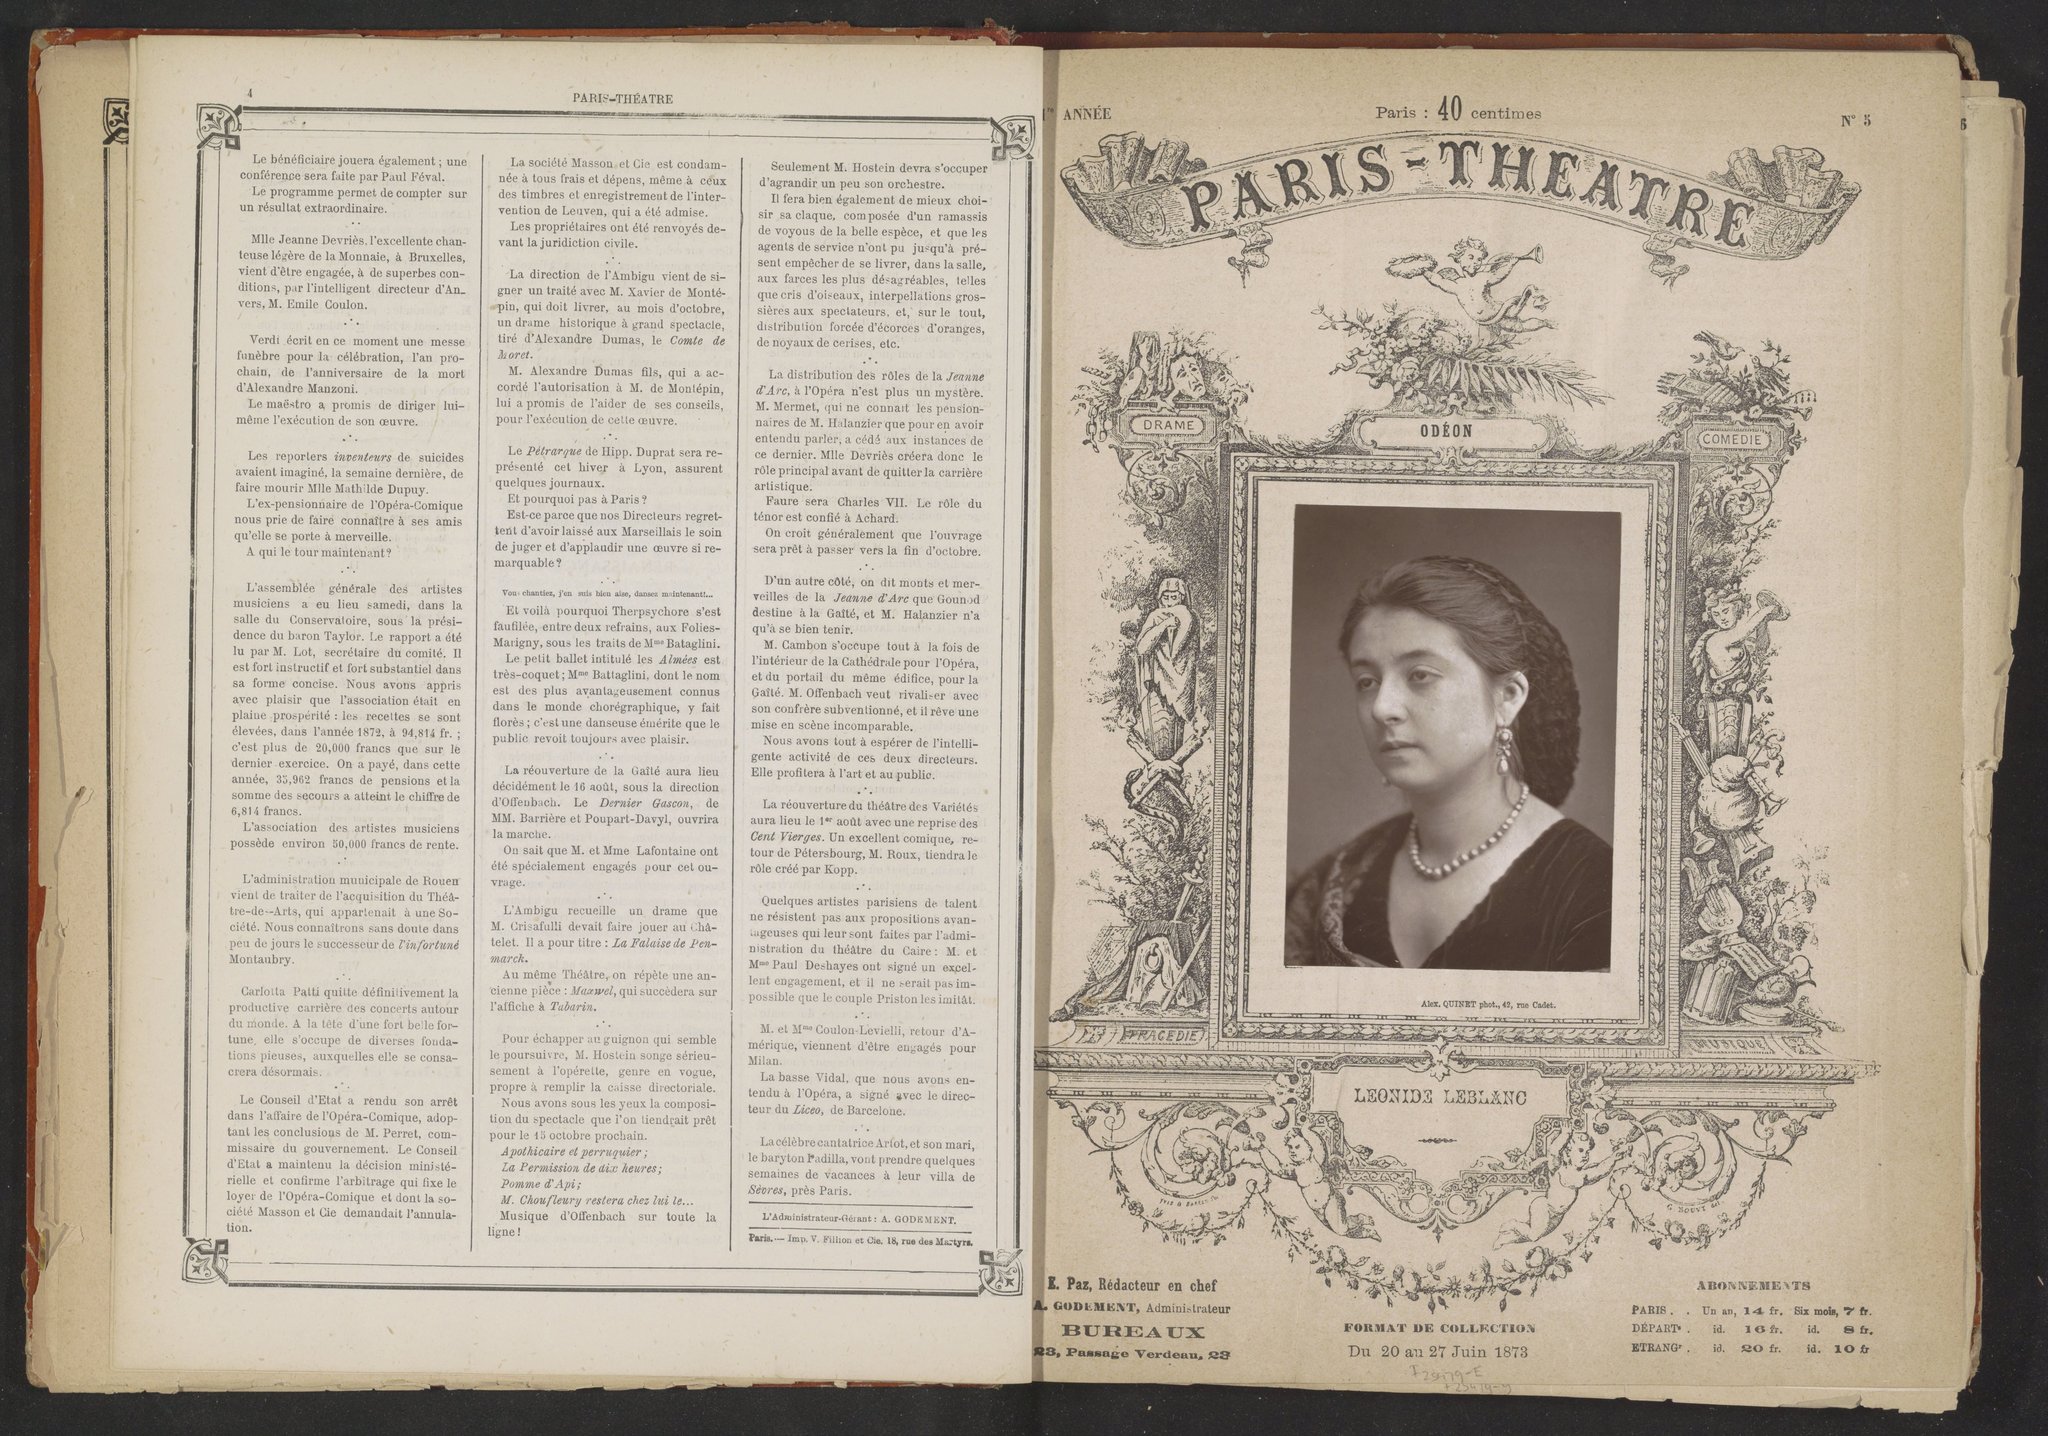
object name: page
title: Portret van Léonide Leblanc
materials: paper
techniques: woodburytype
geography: france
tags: portrait of actor, actress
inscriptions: number: ‘No 5’, inscription: ‘Du 20 au 27 Juin 1873’, name: ‘Alex. Quinet phot., 42, rue Cadet.’